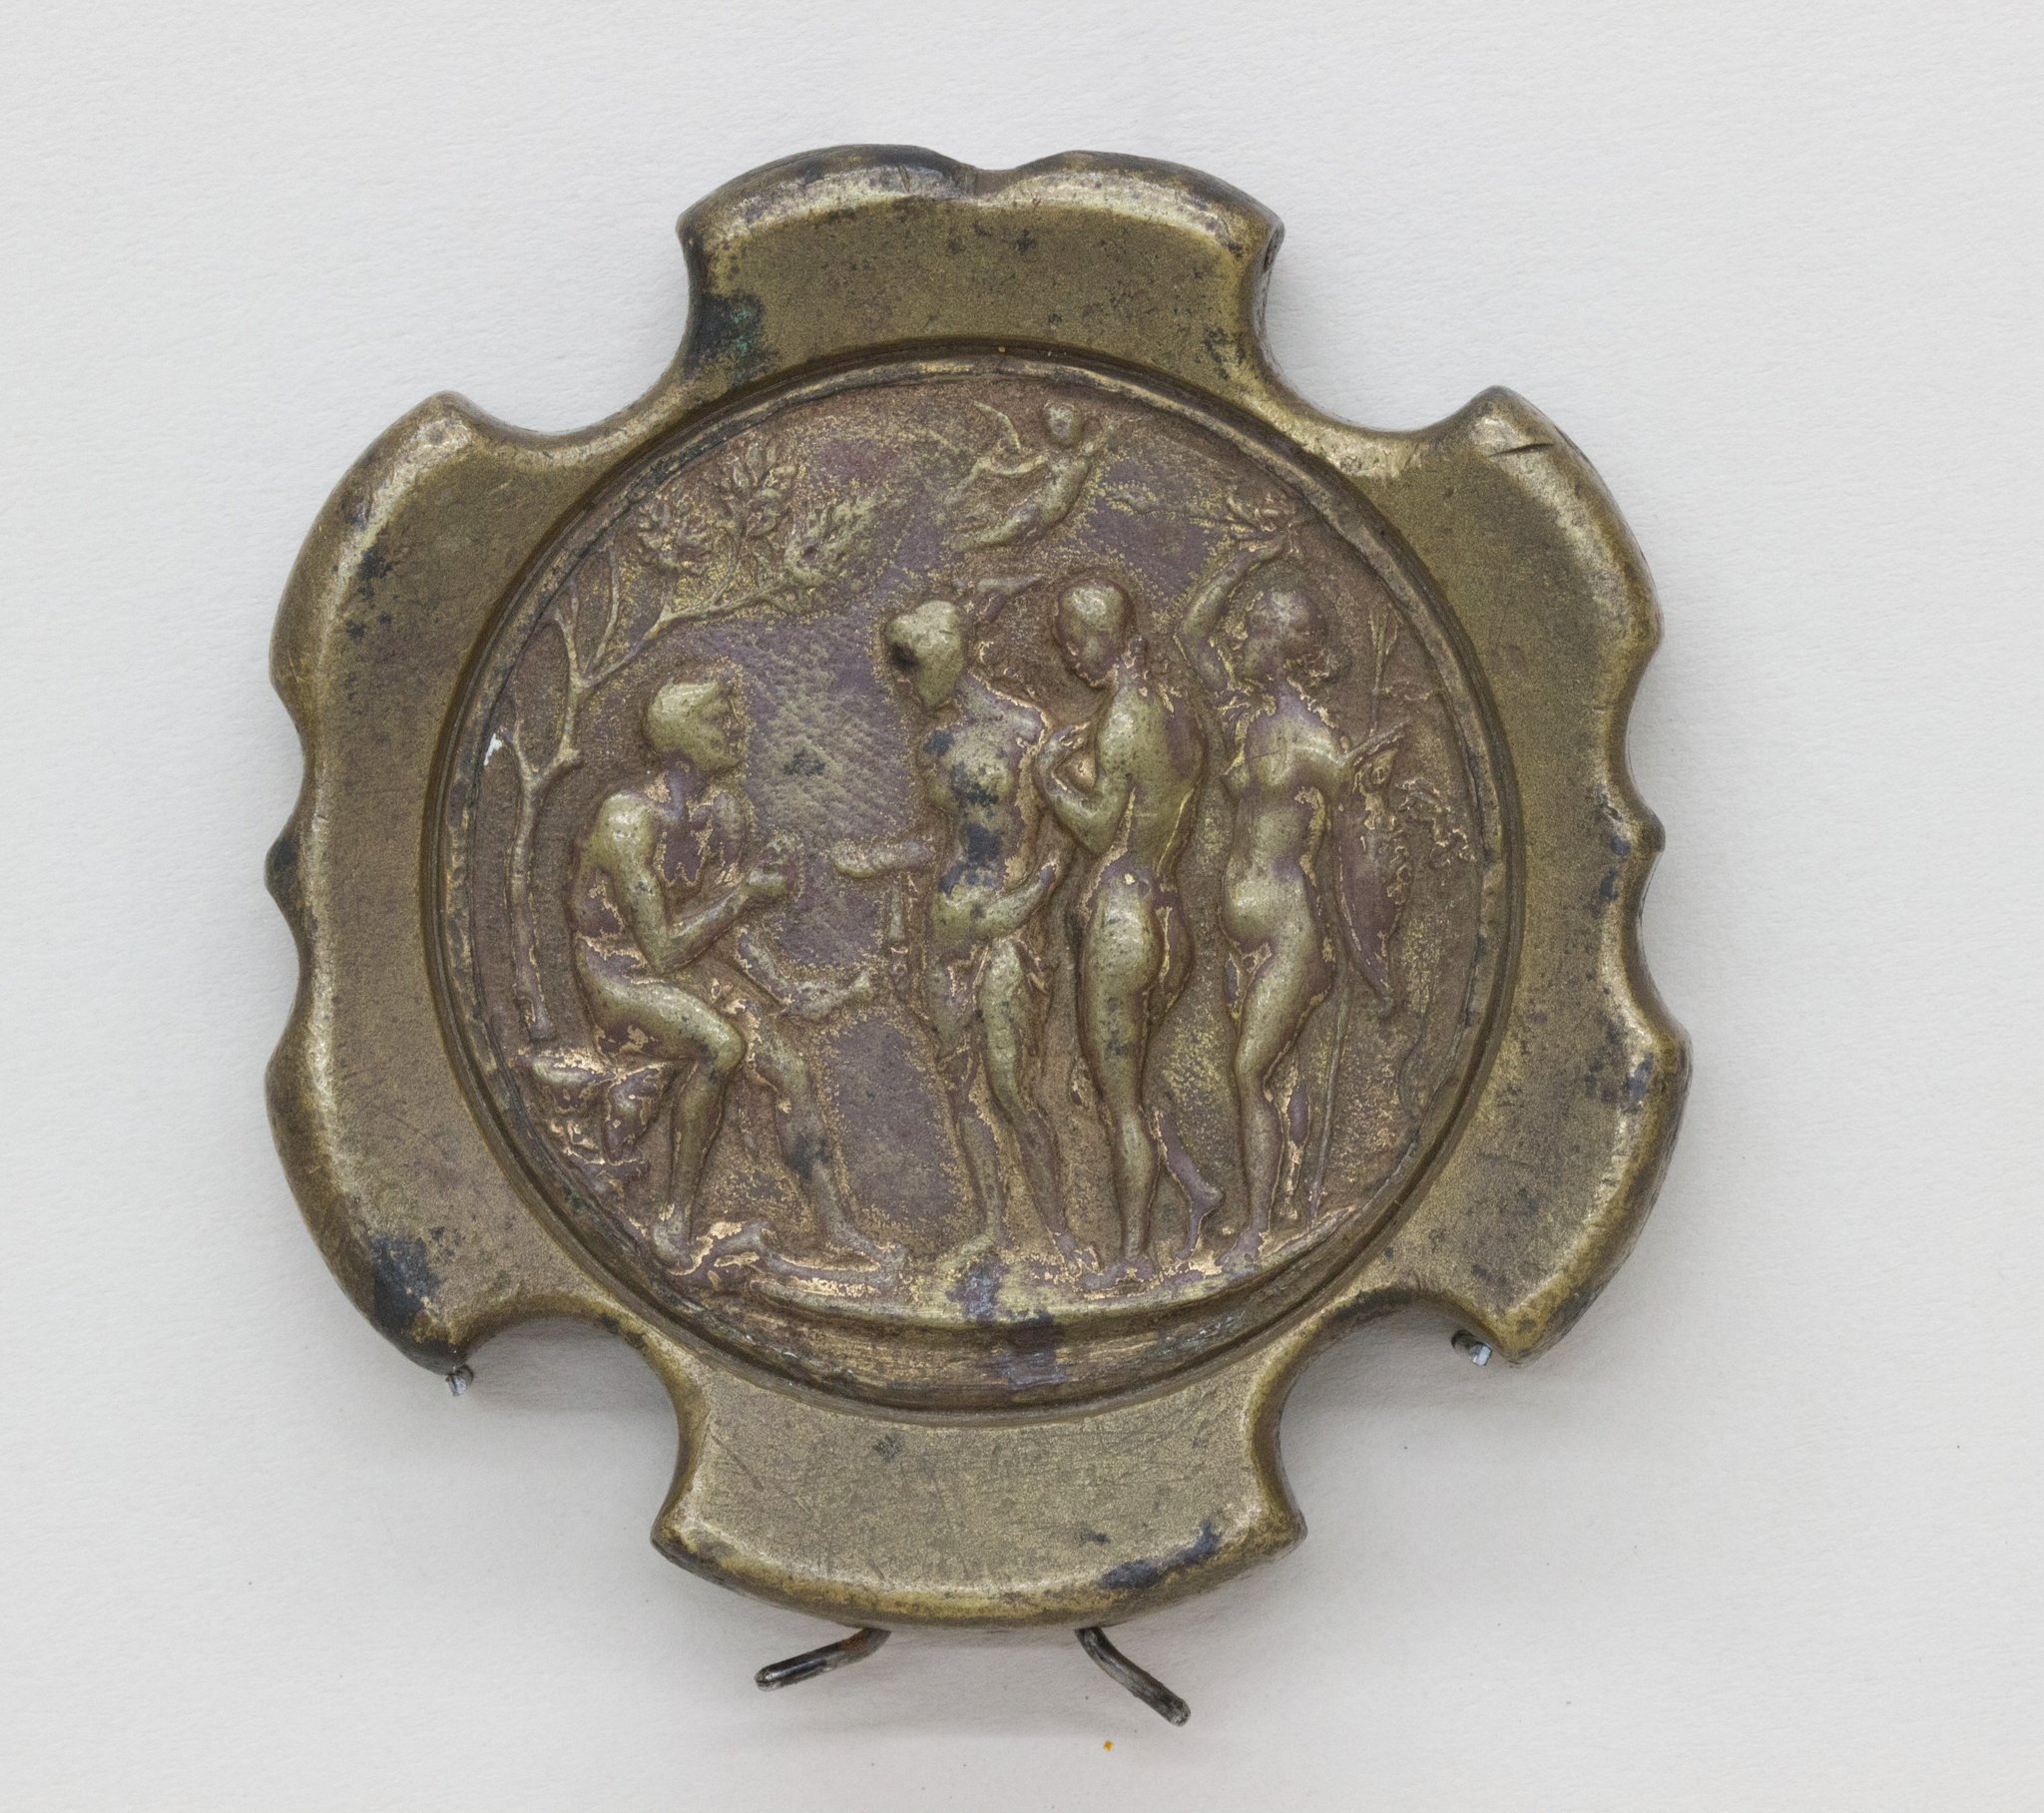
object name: sword pommel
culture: italian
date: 1500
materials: bronze, gold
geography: italy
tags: men,women